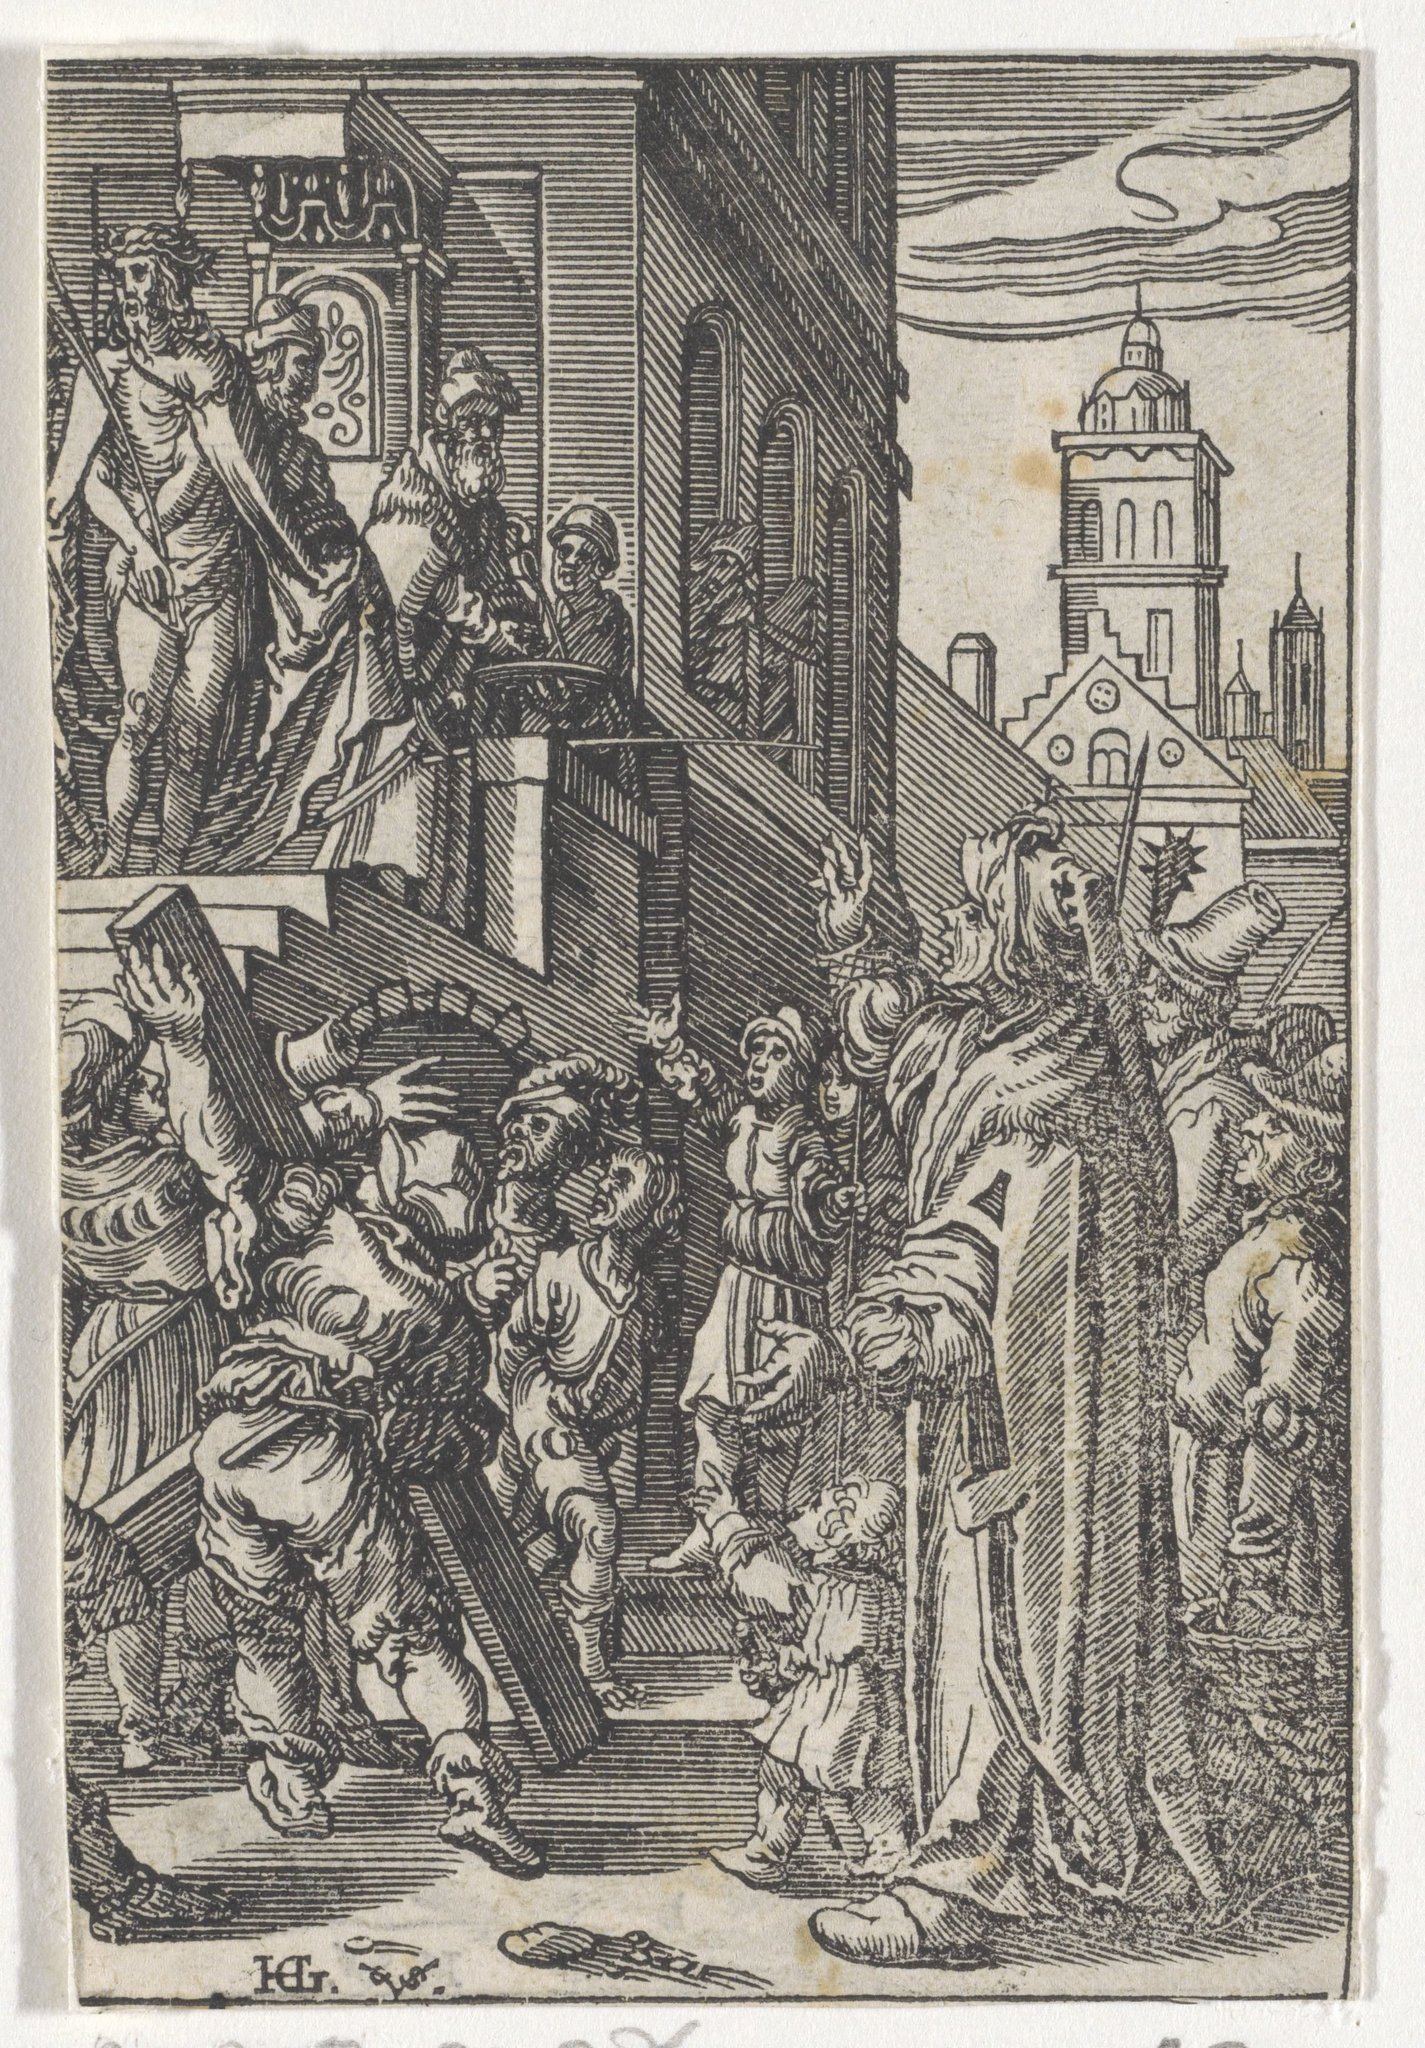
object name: book illustration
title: Christus aan het volk getoond (Ecce Homo)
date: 1648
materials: paper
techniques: woodcut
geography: amsterdam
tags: pilate washing his hands (in innocence), pilate showing christ to the people, 'ostentatio christi', 'ecce homo' (john 19:4-6)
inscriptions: collector's mark: Lugt 240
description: Prent uit: Sichem, Christoffel van (II). 'tSchat der zielen, dat is: Het geheele leven ons Heeren Iesu Christi. Amsterdam: Pieter Jacobsz. Paets, 1648. Prent uit: Biblia sacra dat is De geheele Heylighe Schrifture bedeylt in 't Out en Nieu Testament. Amsterdam: Pieter Jacobsz. Paets, 1657.